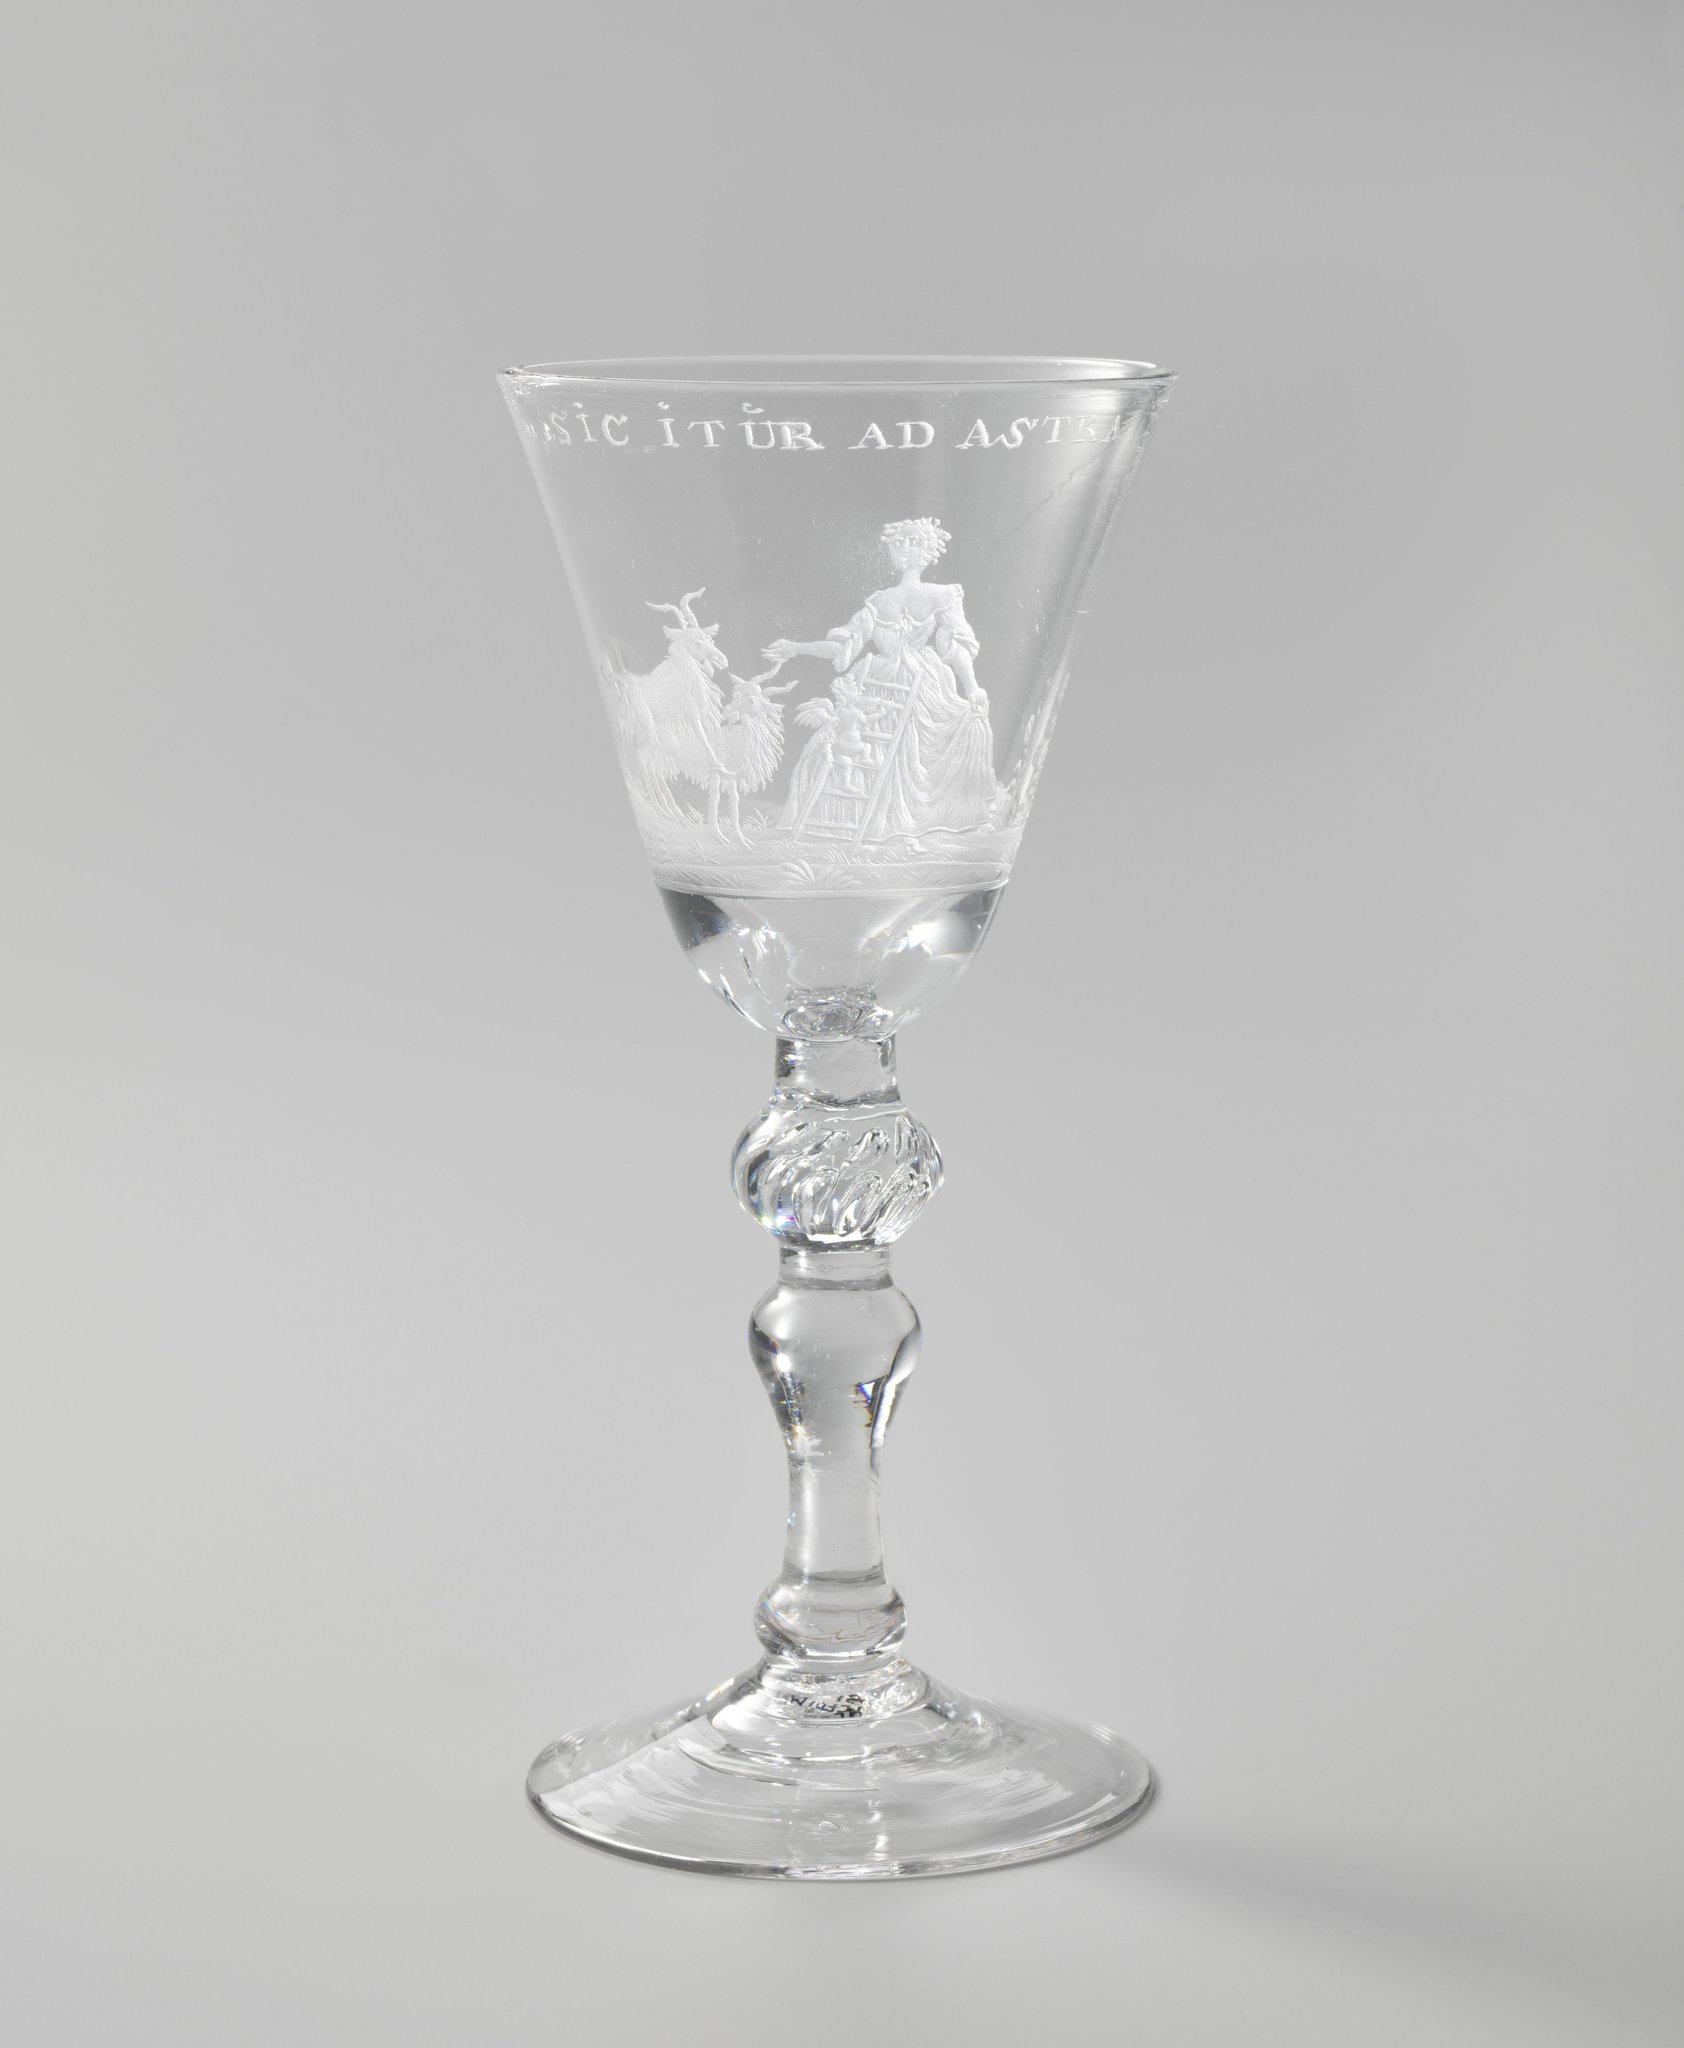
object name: goblet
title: Wine glass with a woman, a putto and two goats mating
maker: Anonymous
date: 1750-1775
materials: glass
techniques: glassblowing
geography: northern netherlands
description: translation of inscription: This is the way to the stars